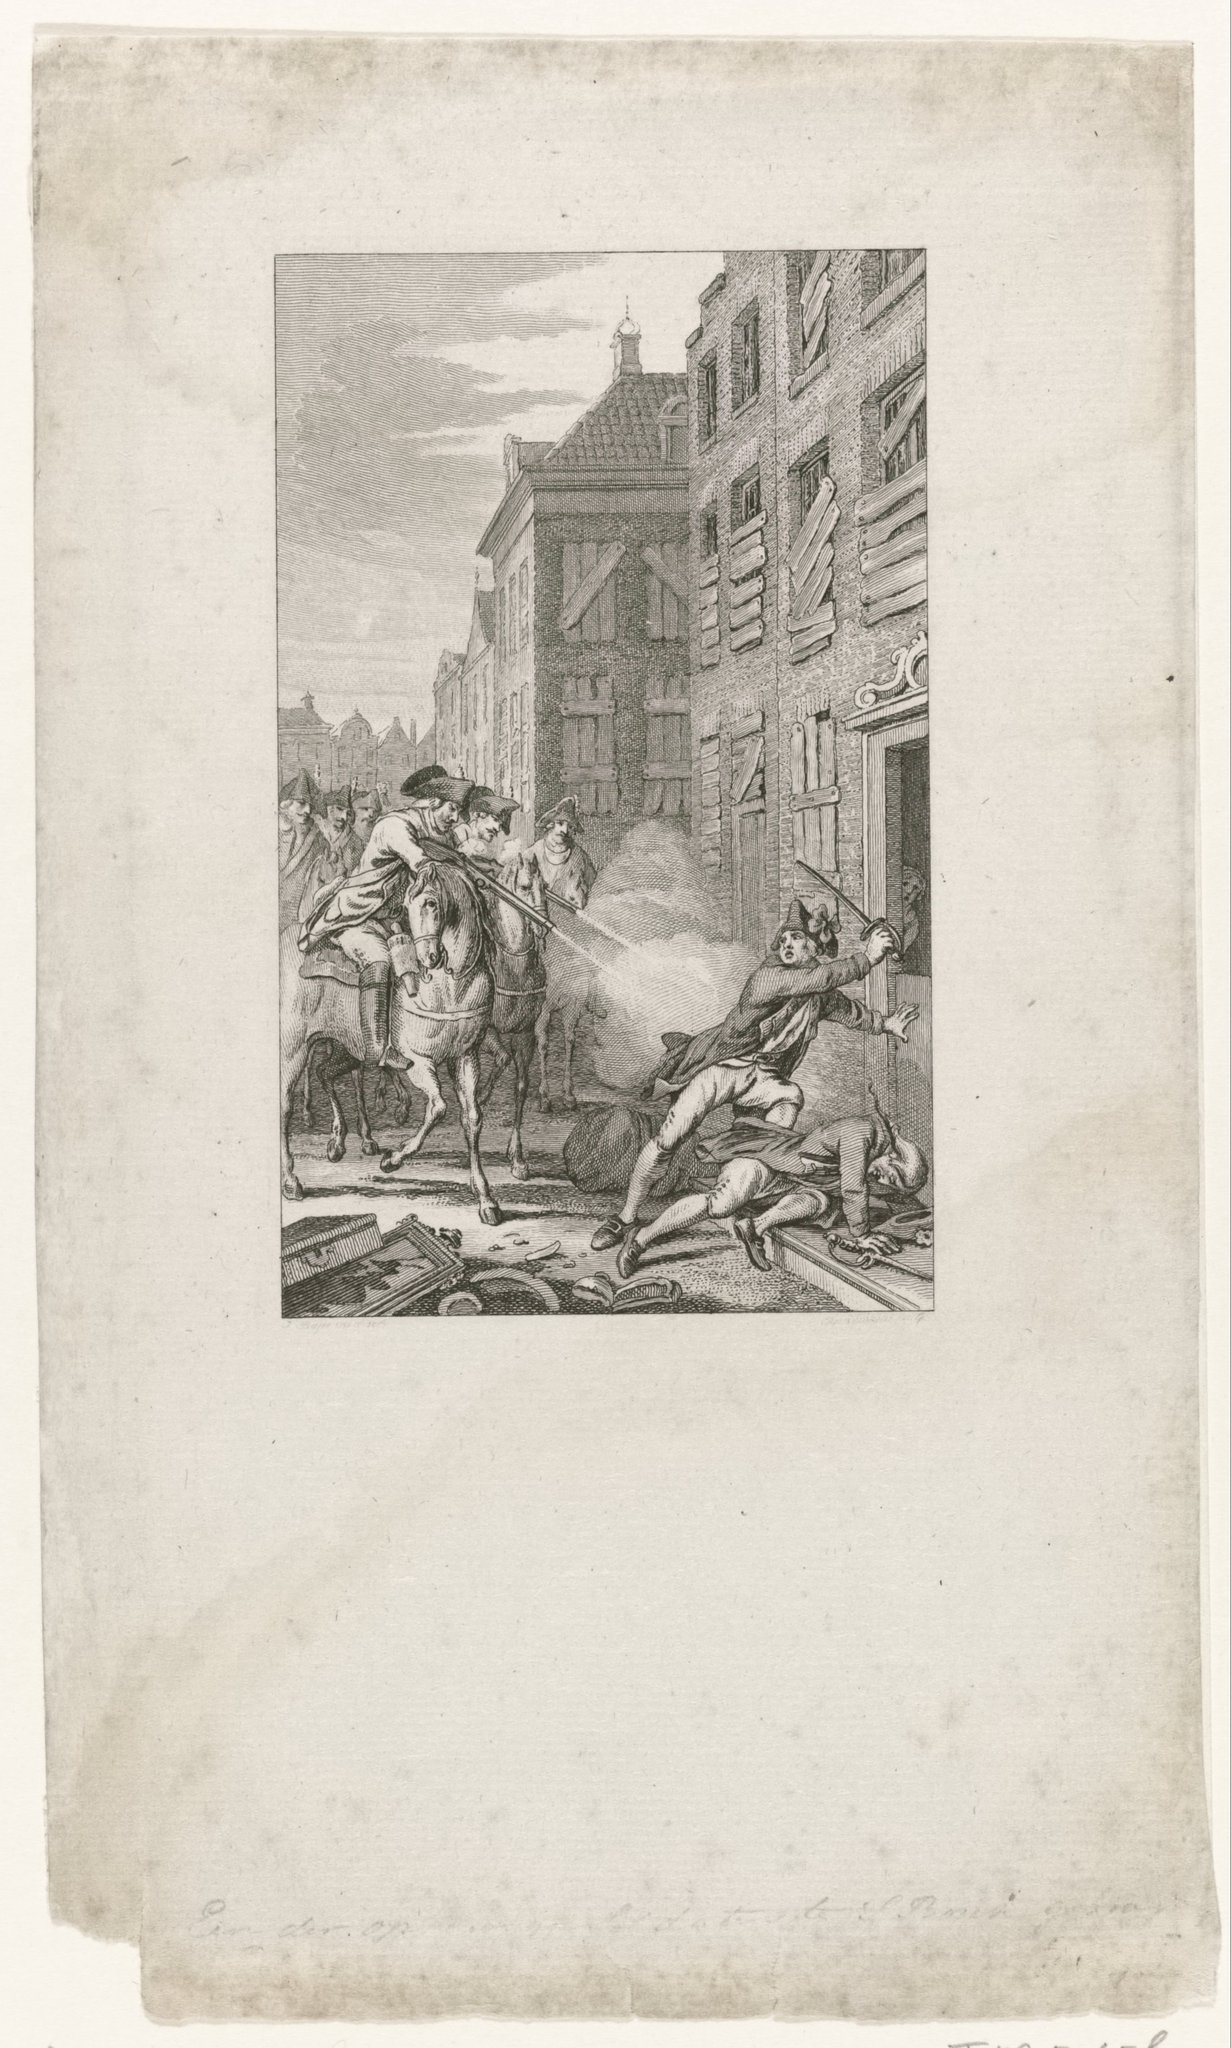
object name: print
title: Bestraffing van twee oproerige soldaten in Den Bosch, 1787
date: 1797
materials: paper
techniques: engraving, etching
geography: northern netherlands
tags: mutiny, rebellion ~ military discipline, den bosch, patriots (1780-1795)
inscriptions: collector's mark: Lugt 2228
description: Gebruikt als illustratie in: P.A. Loosjes. Vaderlandsche historie, vervattende de geschiedenissen, der Vereenigde Nederlanden (...). Ten onmiddelyken vervolge van Wagenaar's Vaderlandsche historie. Amsterdam: Johannes Allart, dl. 19.